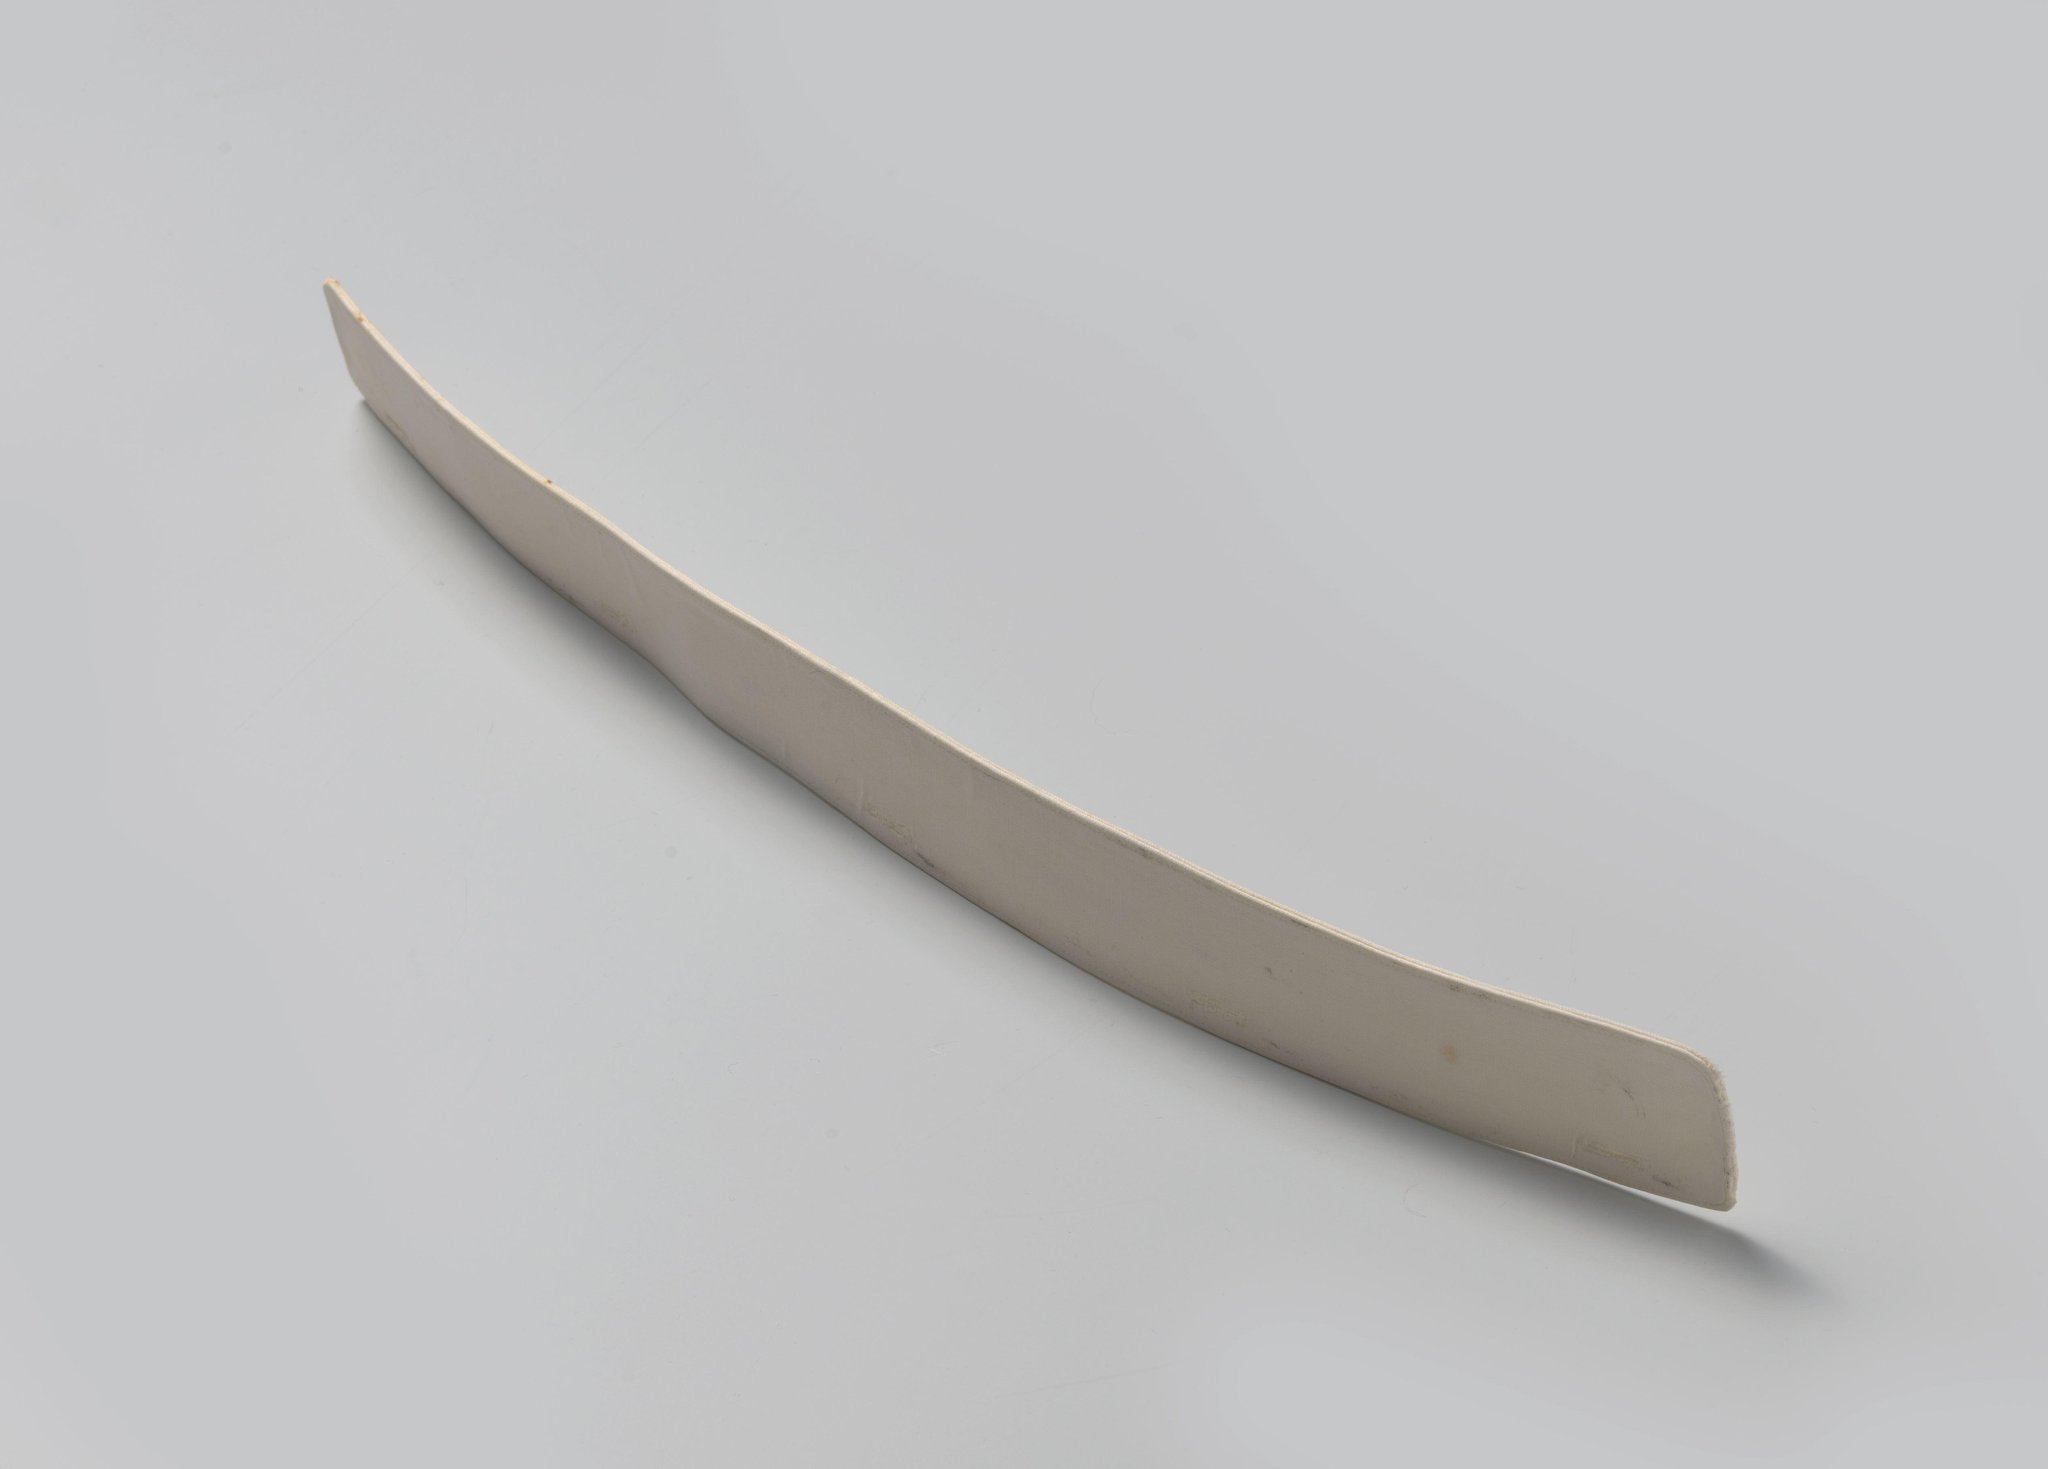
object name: band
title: Boord behorend bij ambtskostuum van H.R. Rookmaker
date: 1933-1957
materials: cardboard, linen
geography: surabaya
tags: dutch east indies, the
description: Boord behorend bij ambtskostuum van H.R. Rookmaker.